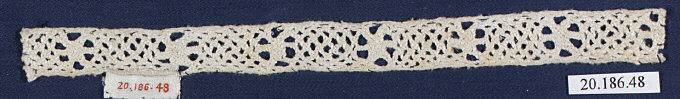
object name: insertion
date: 1501-1600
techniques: lace